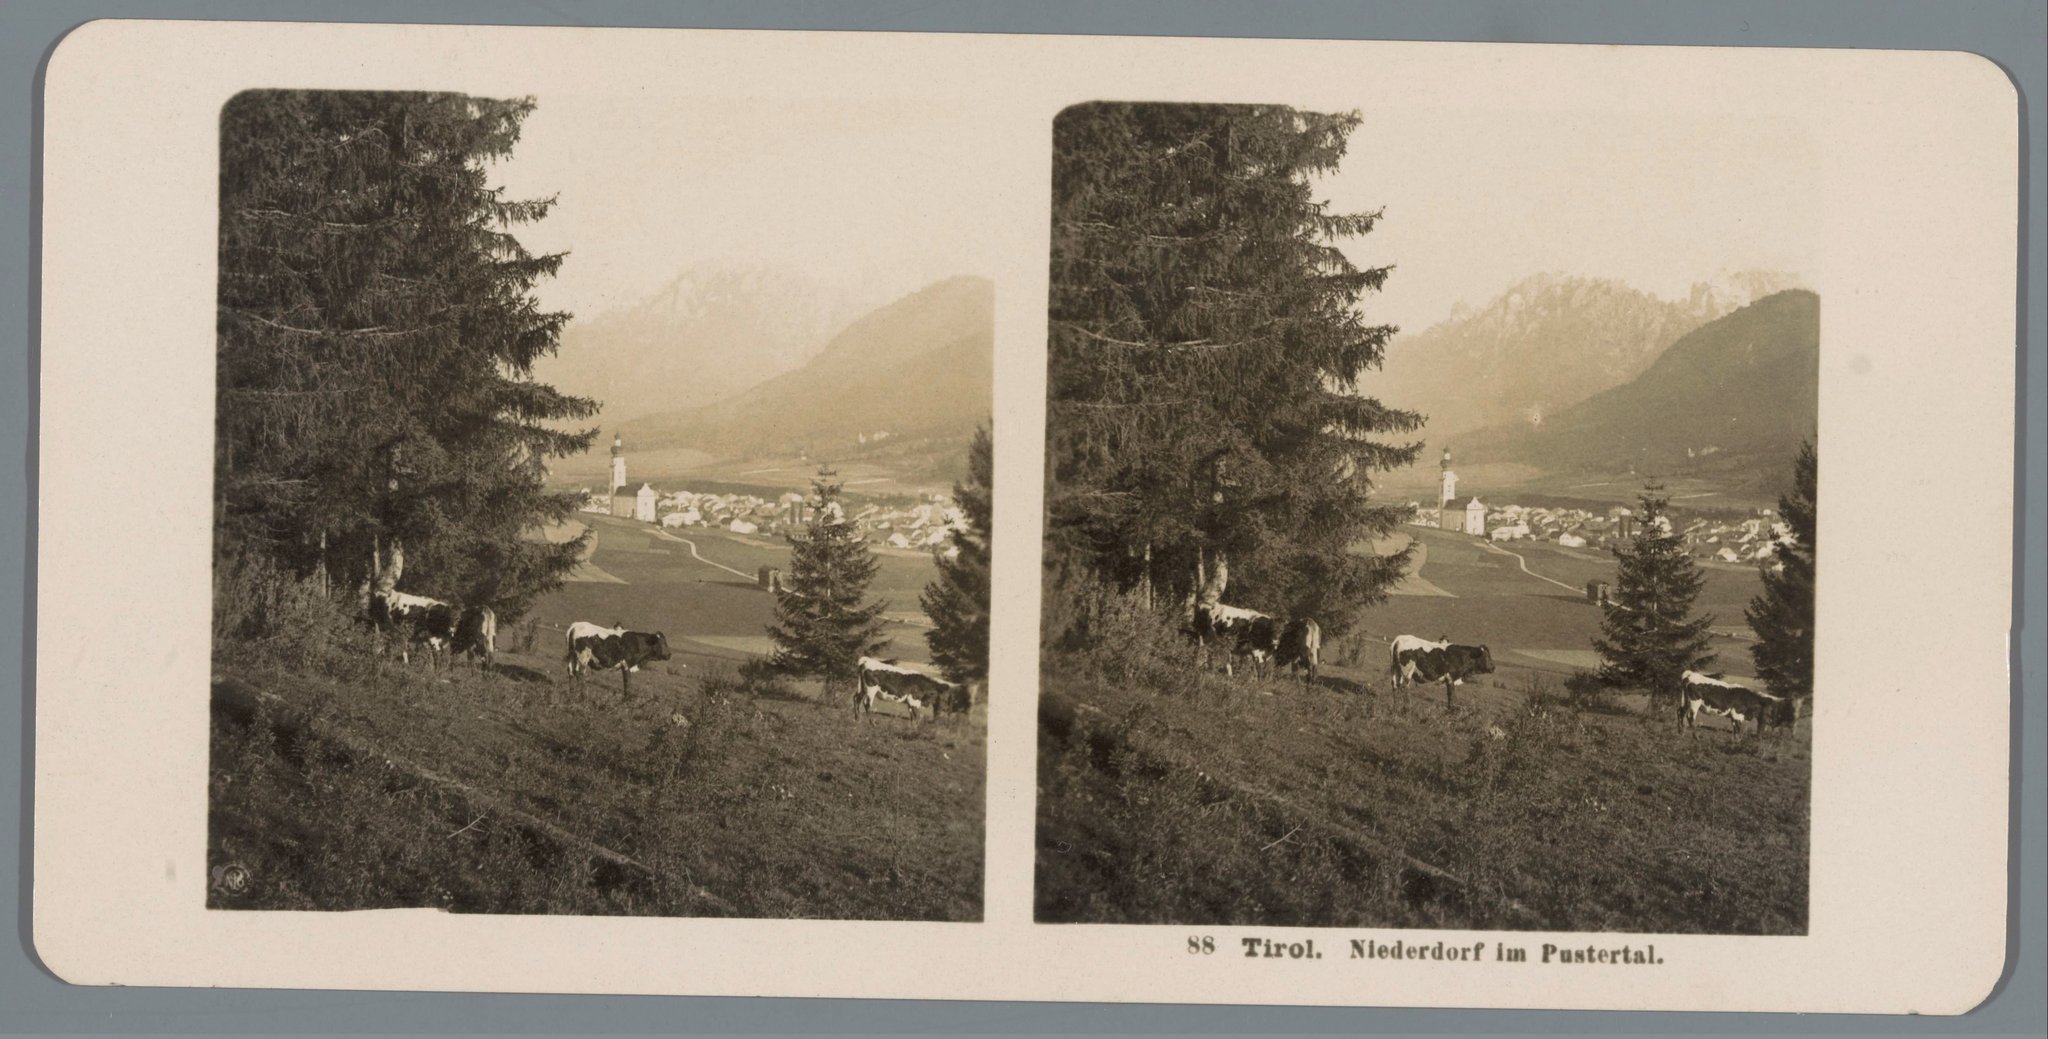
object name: stereograph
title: Tirol. Niederdorf im Pustertal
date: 1900-1910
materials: cardboard, photographic support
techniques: gelatin silver print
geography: tirol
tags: city-view in general; 'veduta', mountains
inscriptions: inscription: ‘NPG’, number: ‘88’